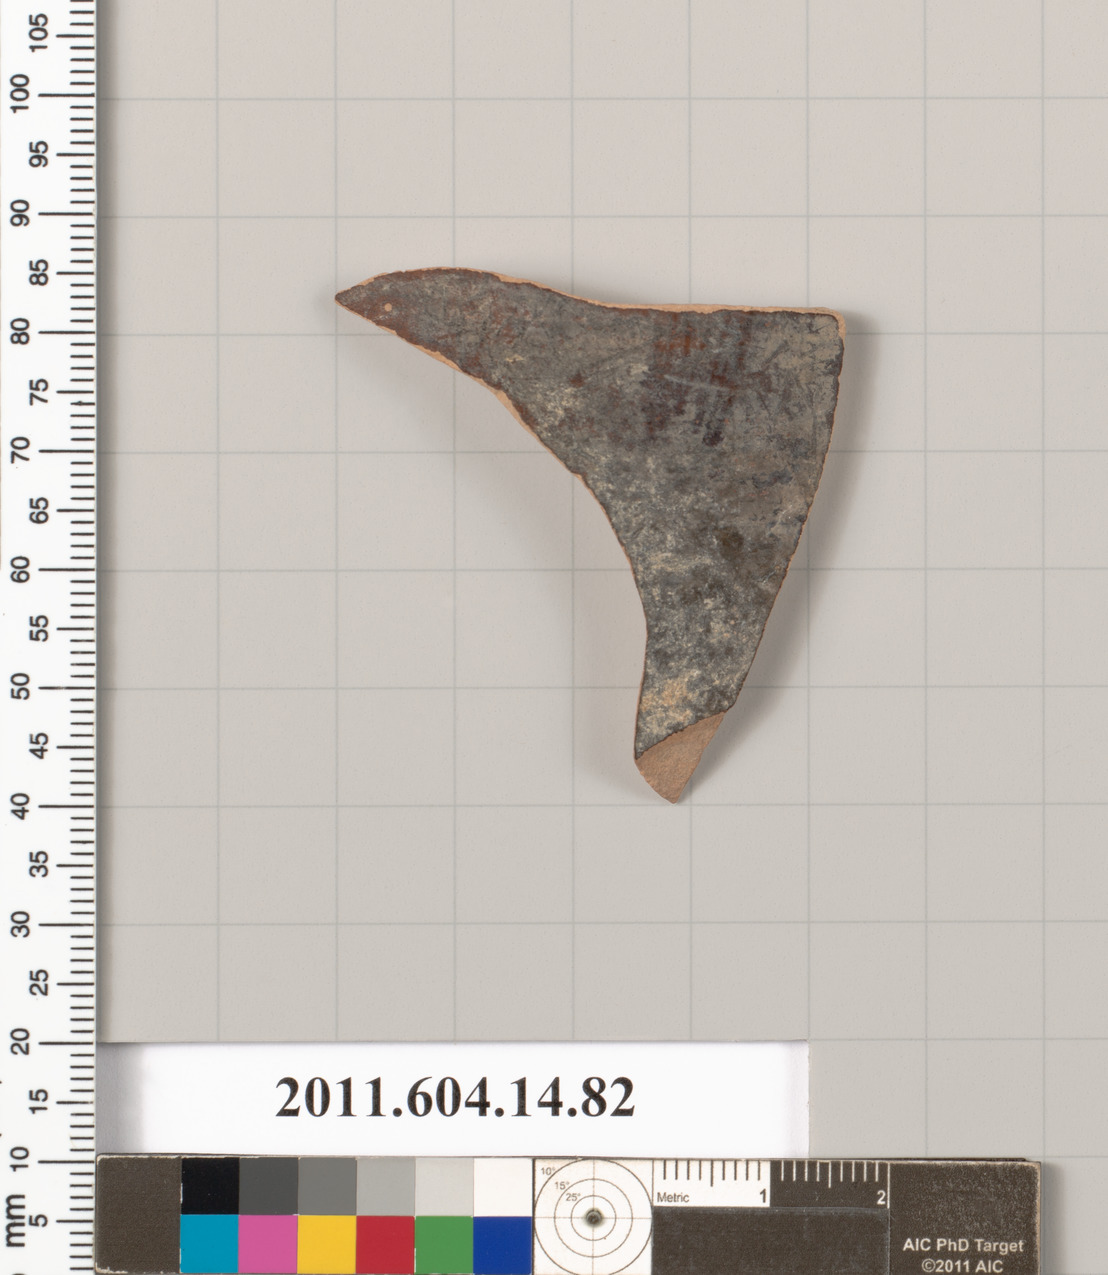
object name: undetermined closed shape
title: Terracotta fragment of a closed shape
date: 600-501 BCE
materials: terracotta